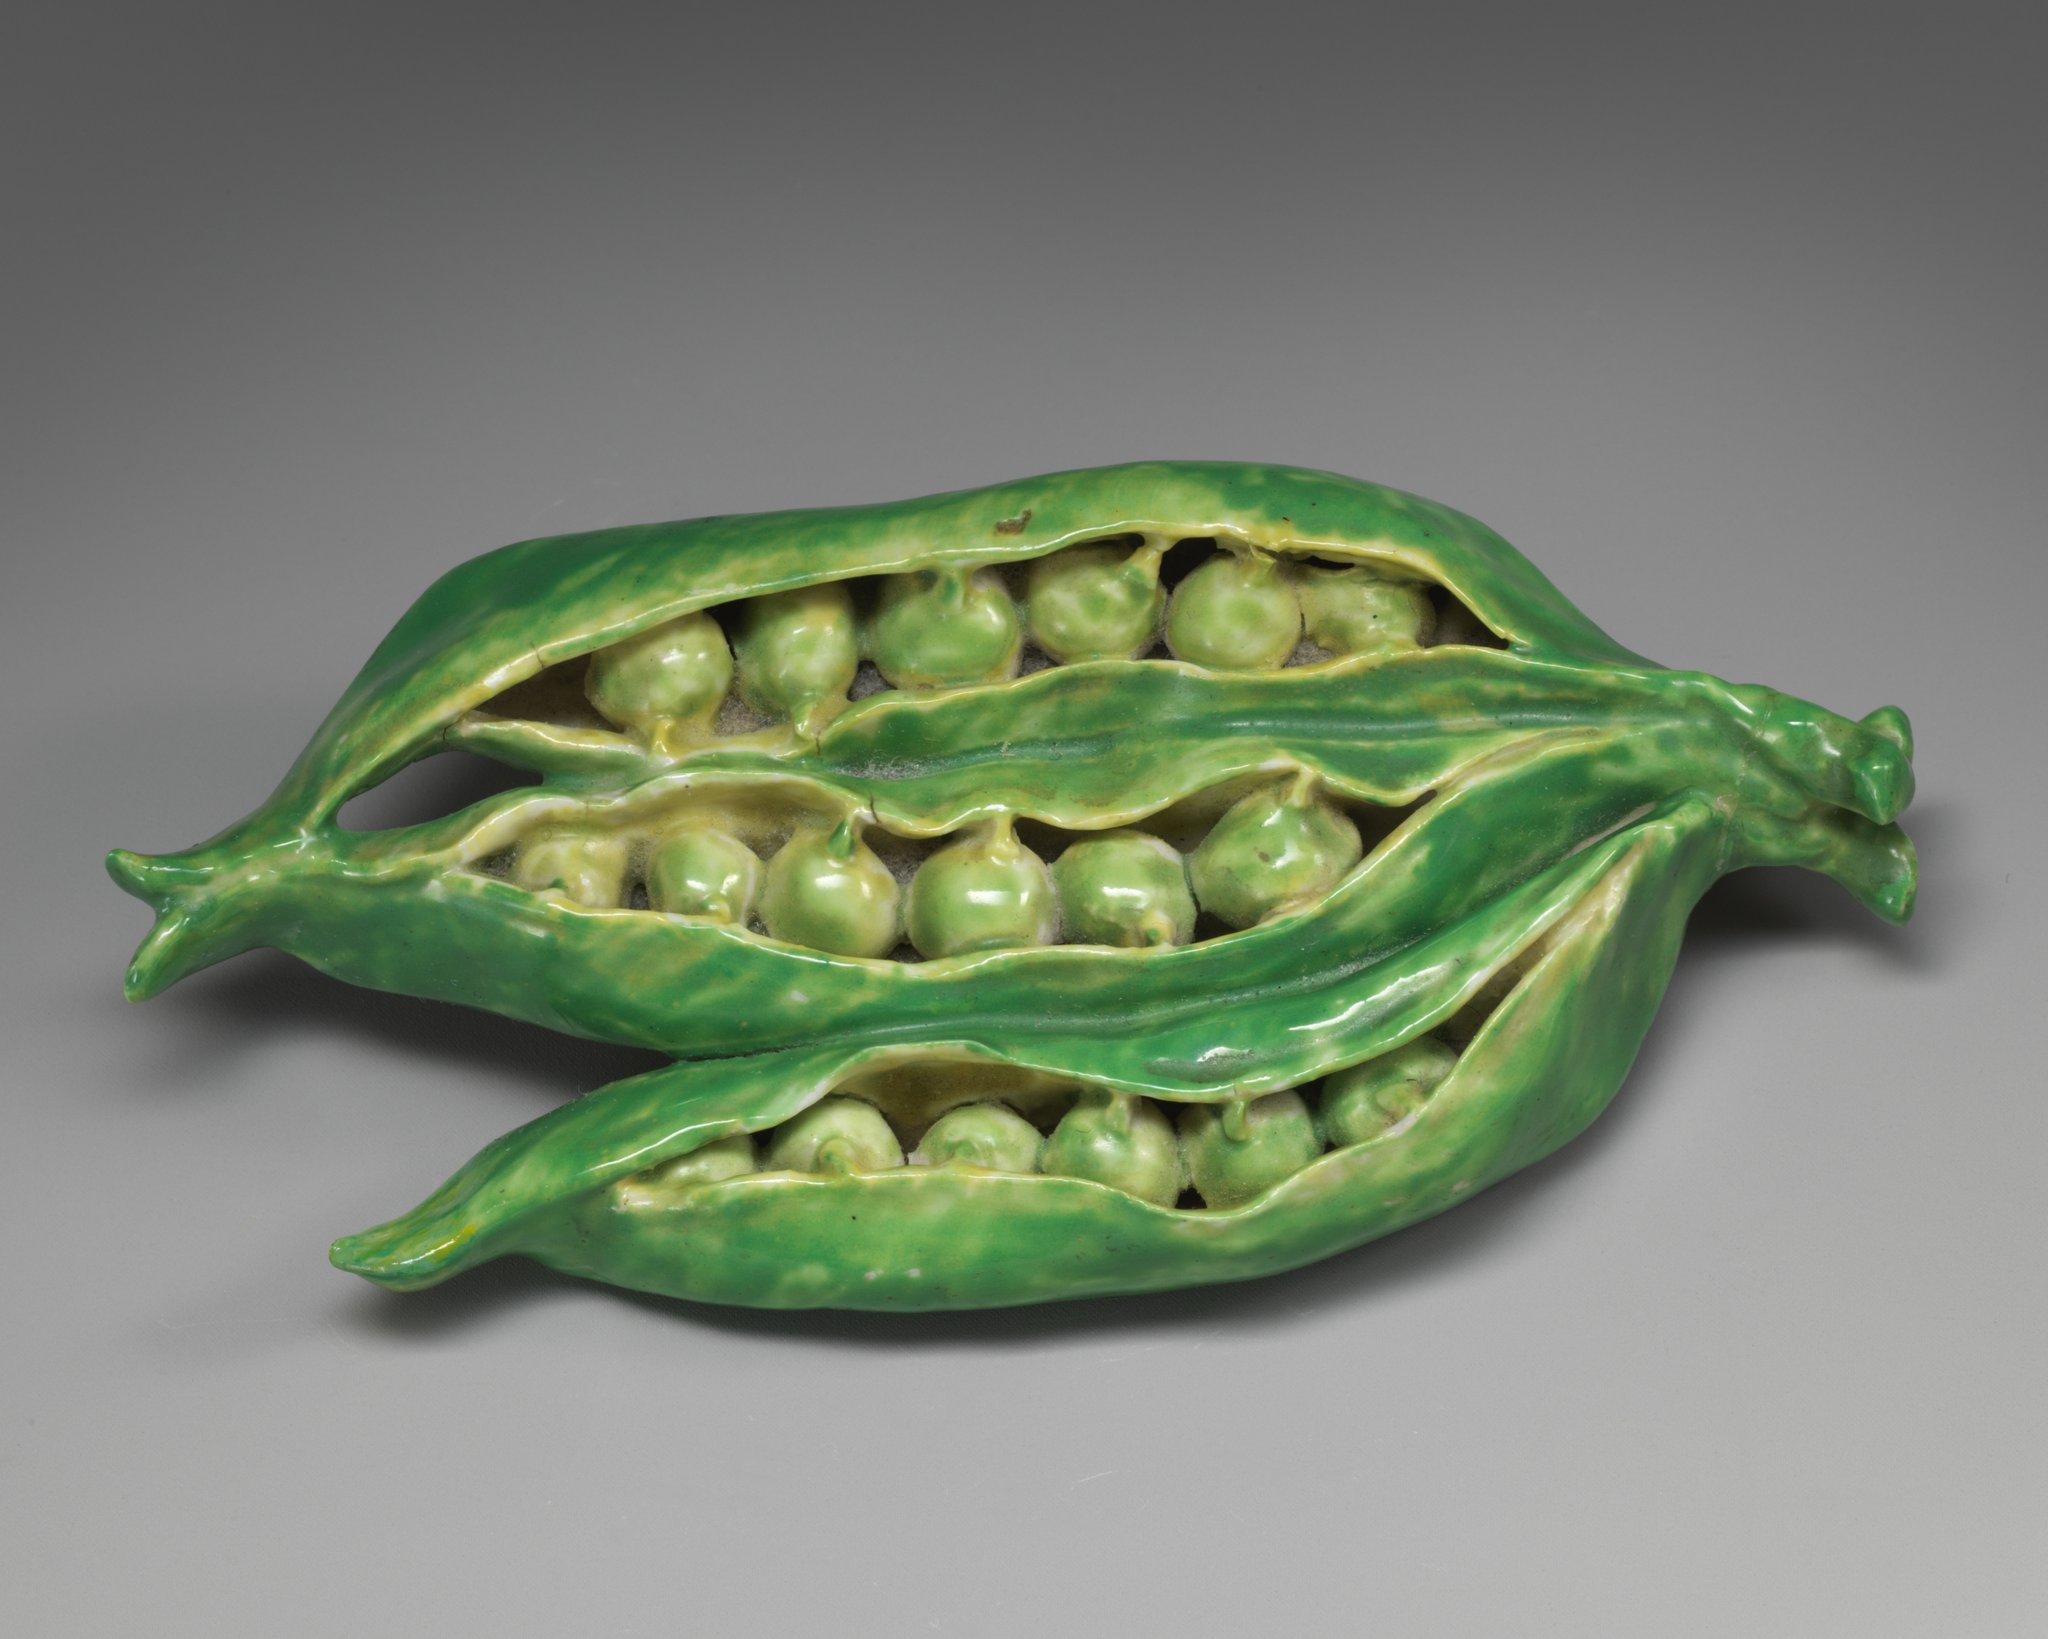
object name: peapod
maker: chelsea porcelain manufactory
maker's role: factory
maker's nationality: british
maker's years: 1744-1784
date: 1755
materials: enamel, soft paste porcelain